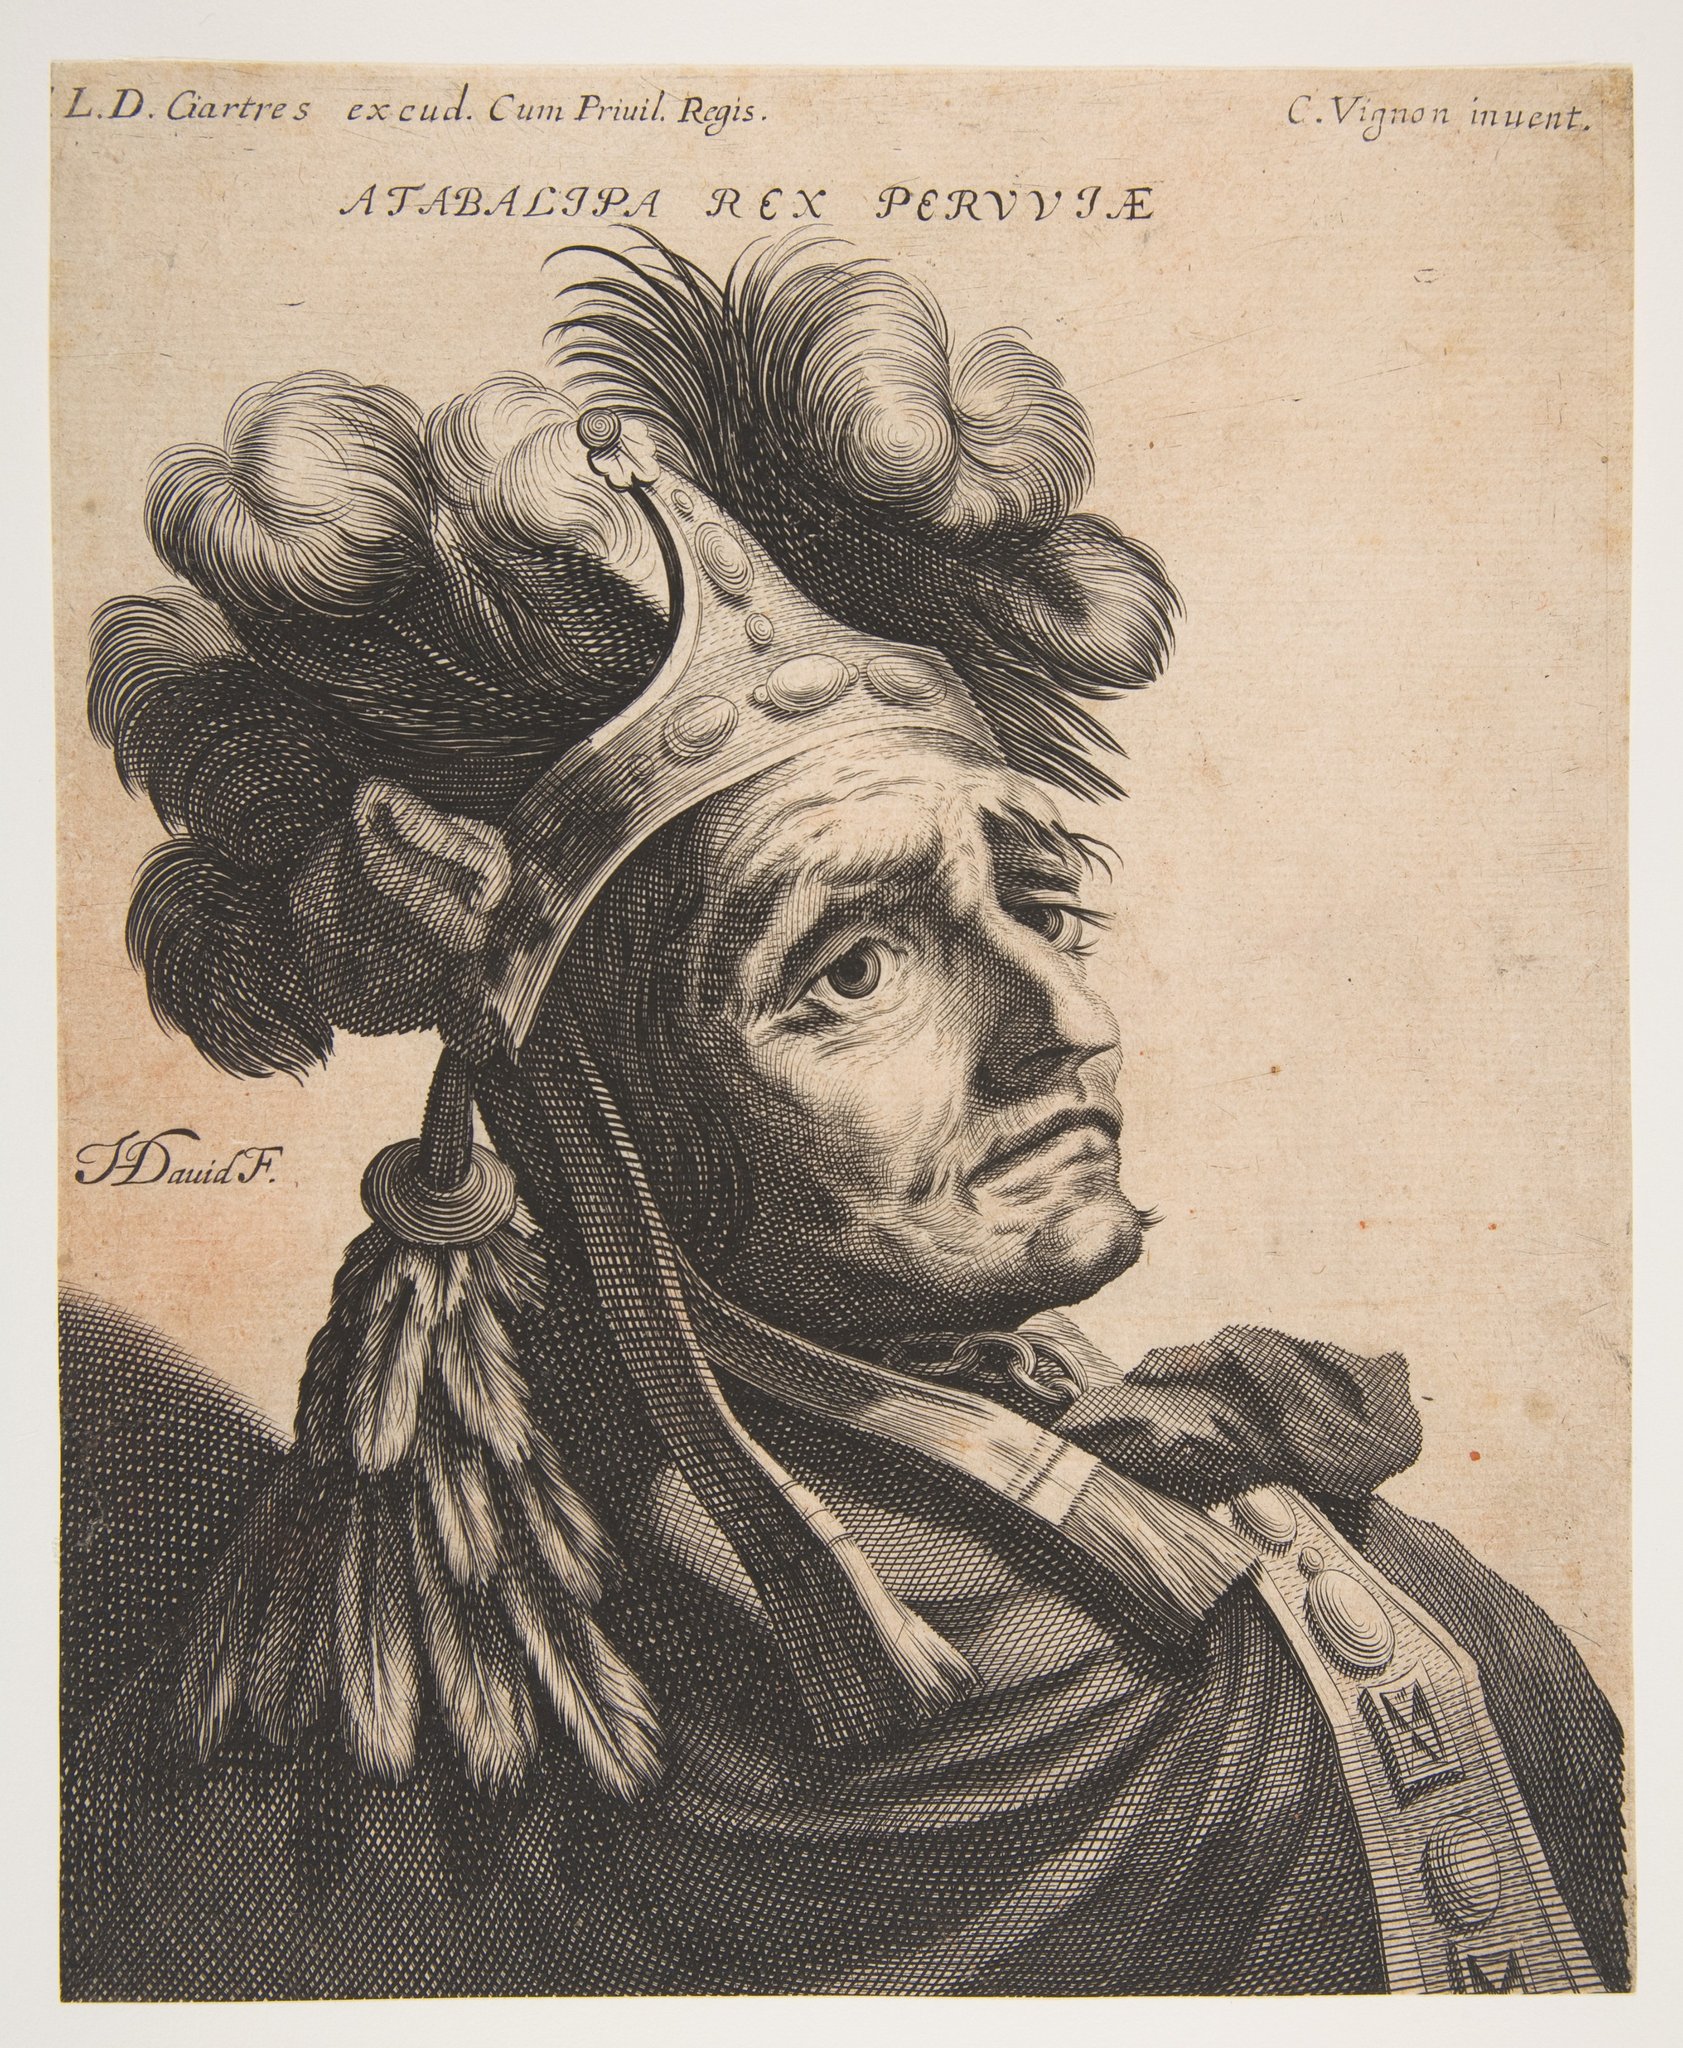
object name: print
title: Atabalipa, Roi du Pérou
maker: jerôme david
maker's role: artist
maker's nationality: french?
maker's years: 1605-1670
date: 1634-1637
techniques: engraving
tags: kings,portraits